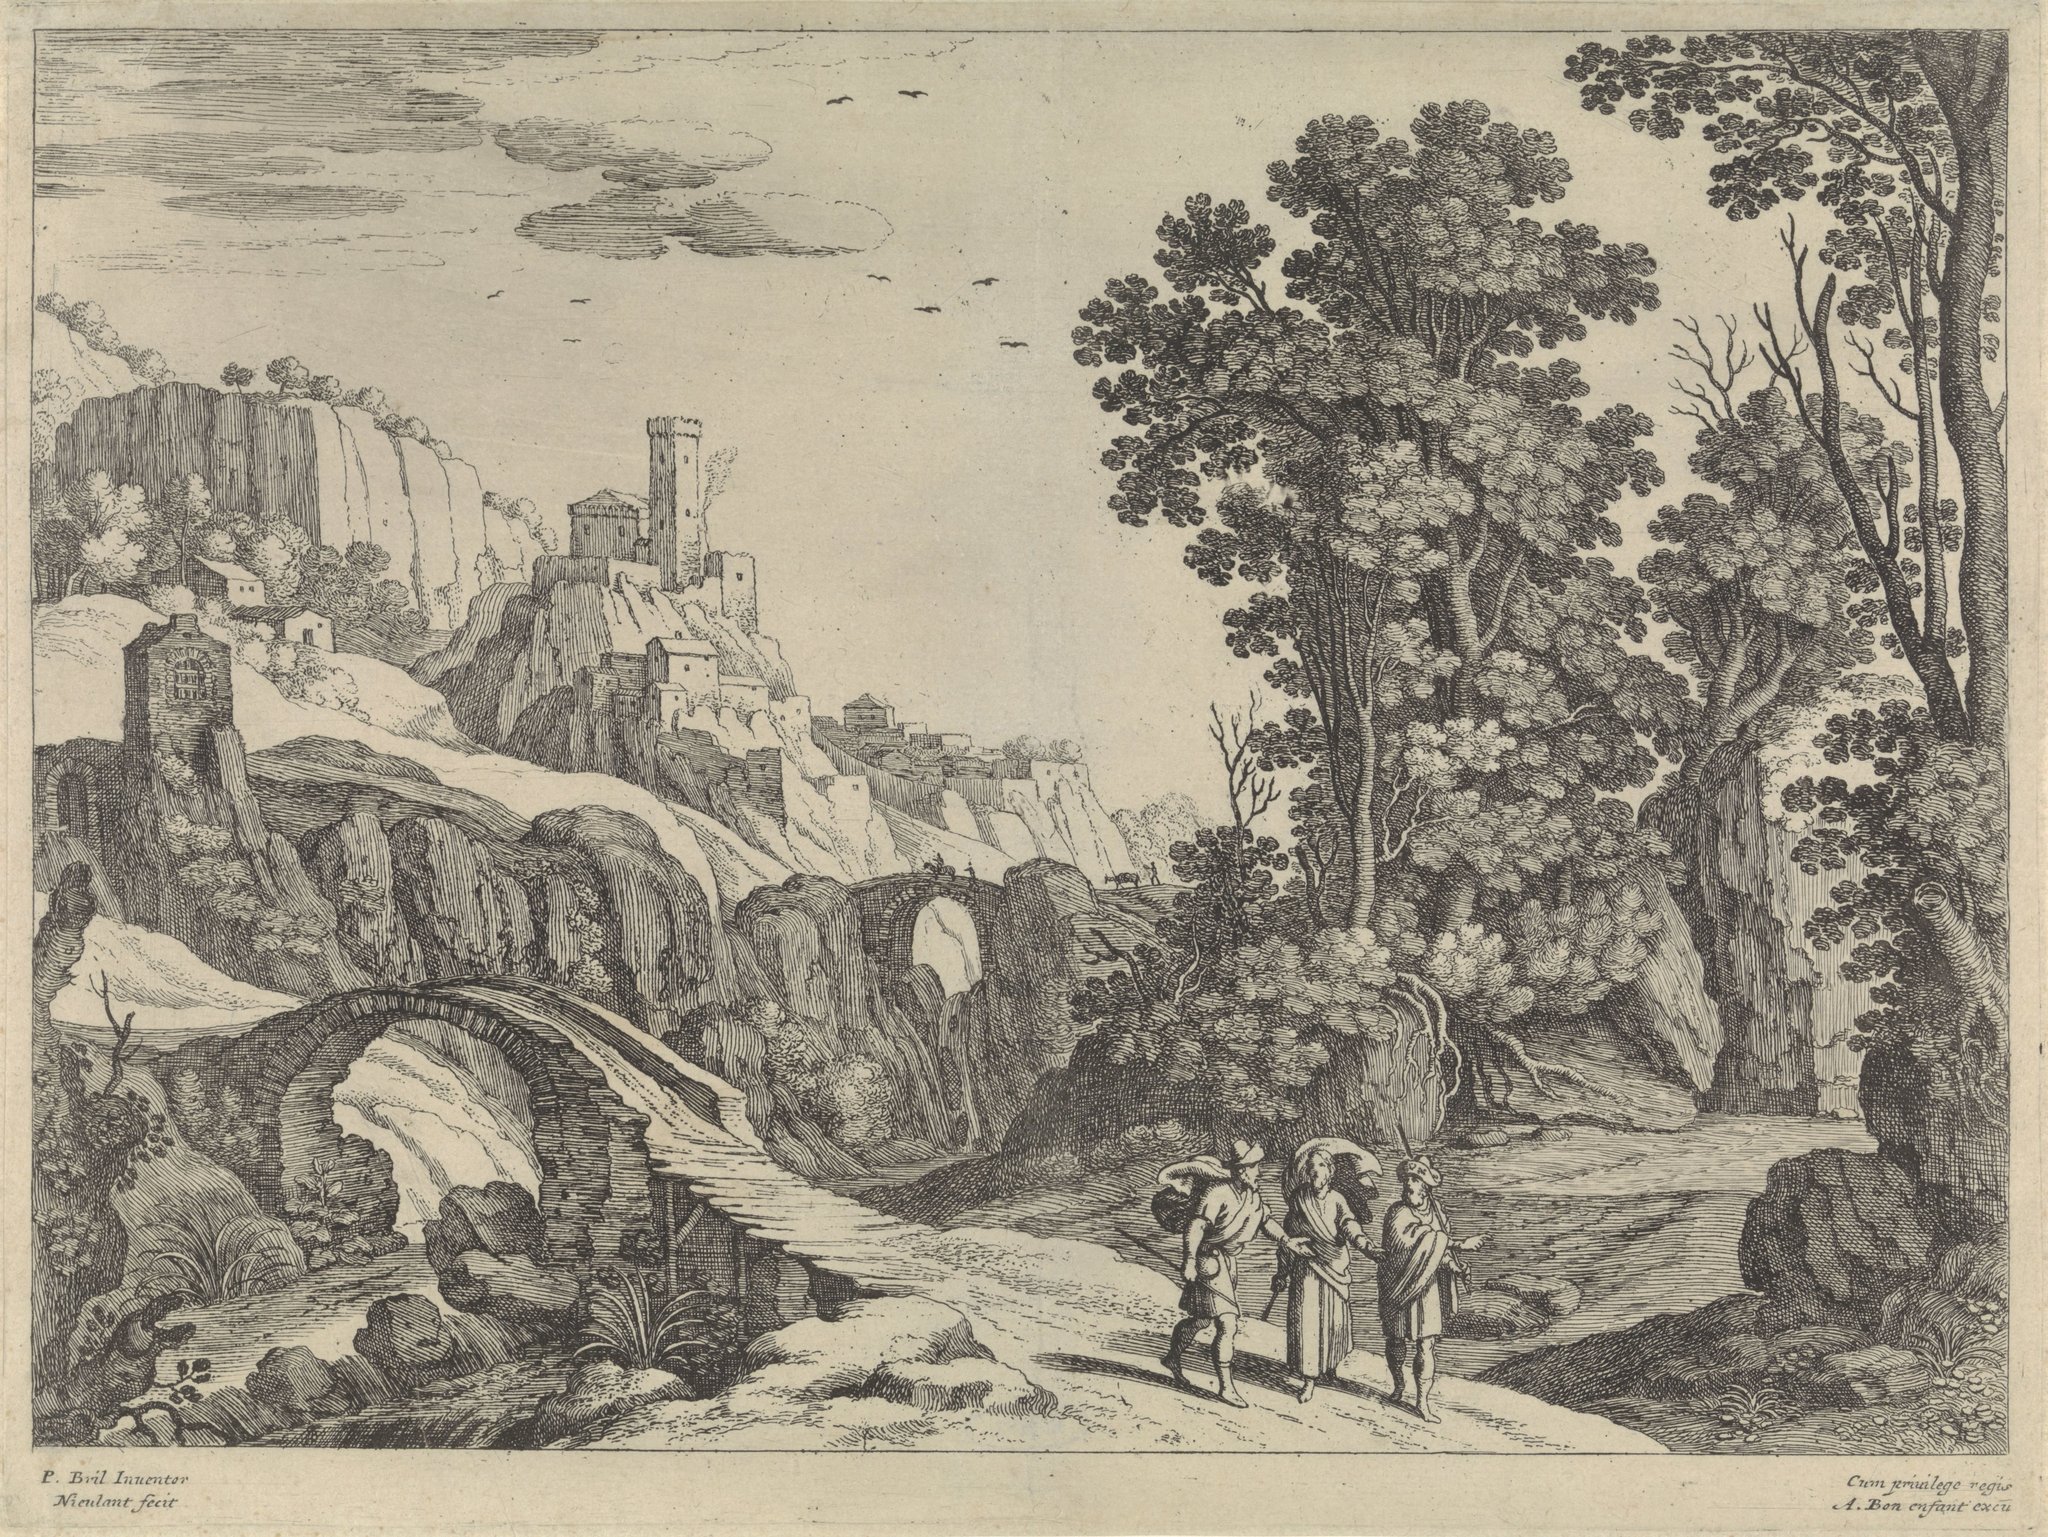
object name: print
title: Landschap met de Emmaüsgangers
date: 1594-1635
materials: paper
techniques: engraving, etching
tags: landscapes in the temperate zone, cleopas and peter meet christ (sometimes they are dressed as pilgrims)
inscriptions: collector's mark: Lugt 2228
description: In een Italiaans landschap, met twee boogvormige bruggen over een rivier, lopen de Emmaüsgangers. Christus loopt tussen hen in. Naar het Bijbelverhaal in Luc. 24: 13-27.